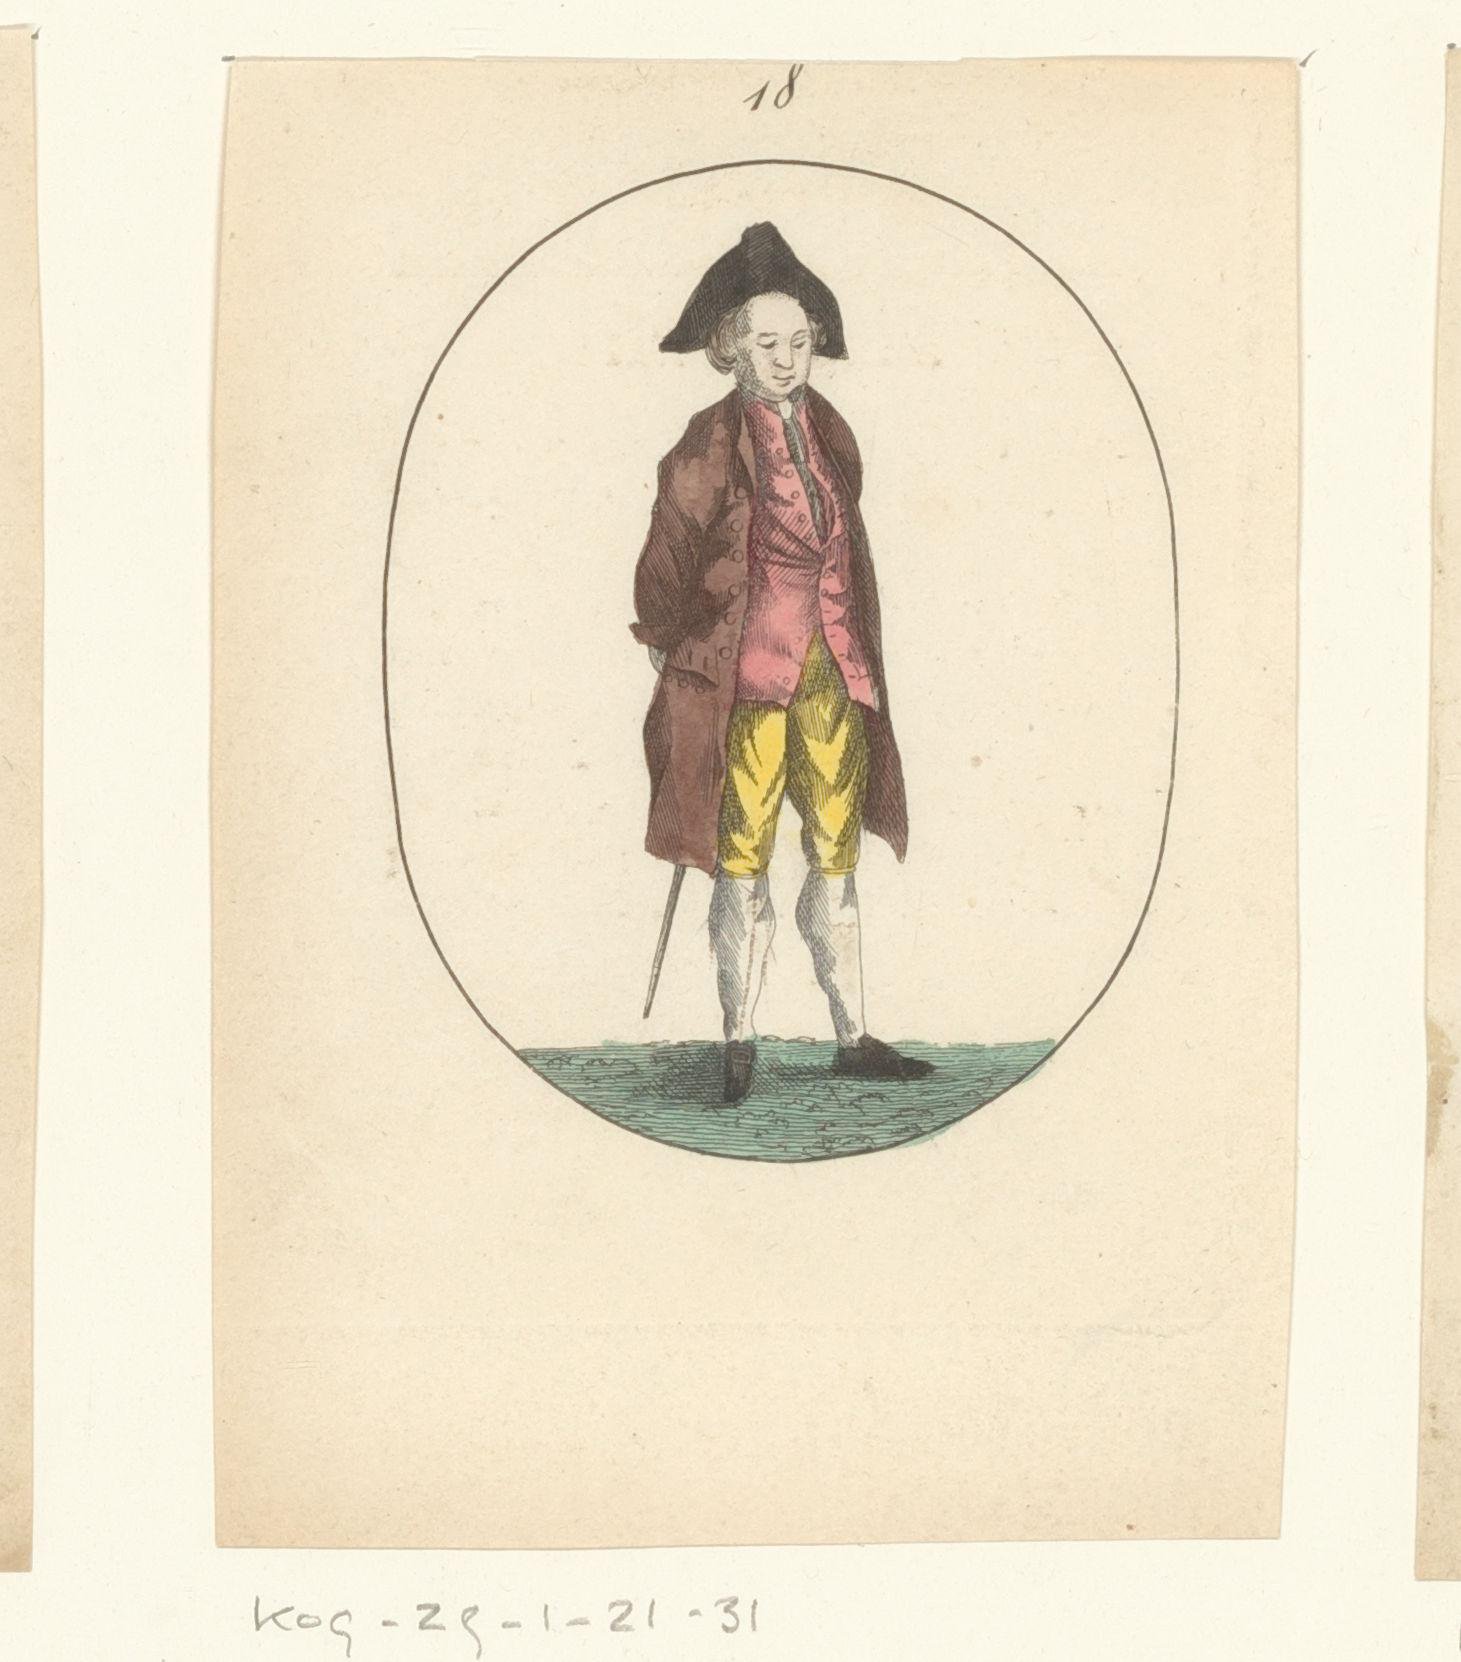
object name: print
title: Staande man met tevreden blik met zijn handen op zijn rug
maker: Anonymous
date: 1750-1849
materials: paper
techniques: etching, hand coloring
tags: standing figure (+ sideview, profile), head-gear: tricorn, coat, historical costume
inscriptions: collector's mark: Lugt 1641, collector's mark: Lugt 1641a, stamp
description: Bovenaan genummerd: 18. Onderwerpsrubrieken binnen de Atlas Zeden en Gewoonten: Zeden en Gewoonten in Engeren Zin, De Kleeding, Kleederdrachten (tijdvakken), De 18de eeuw (de pruikentijd). Mannen en vrouwen.